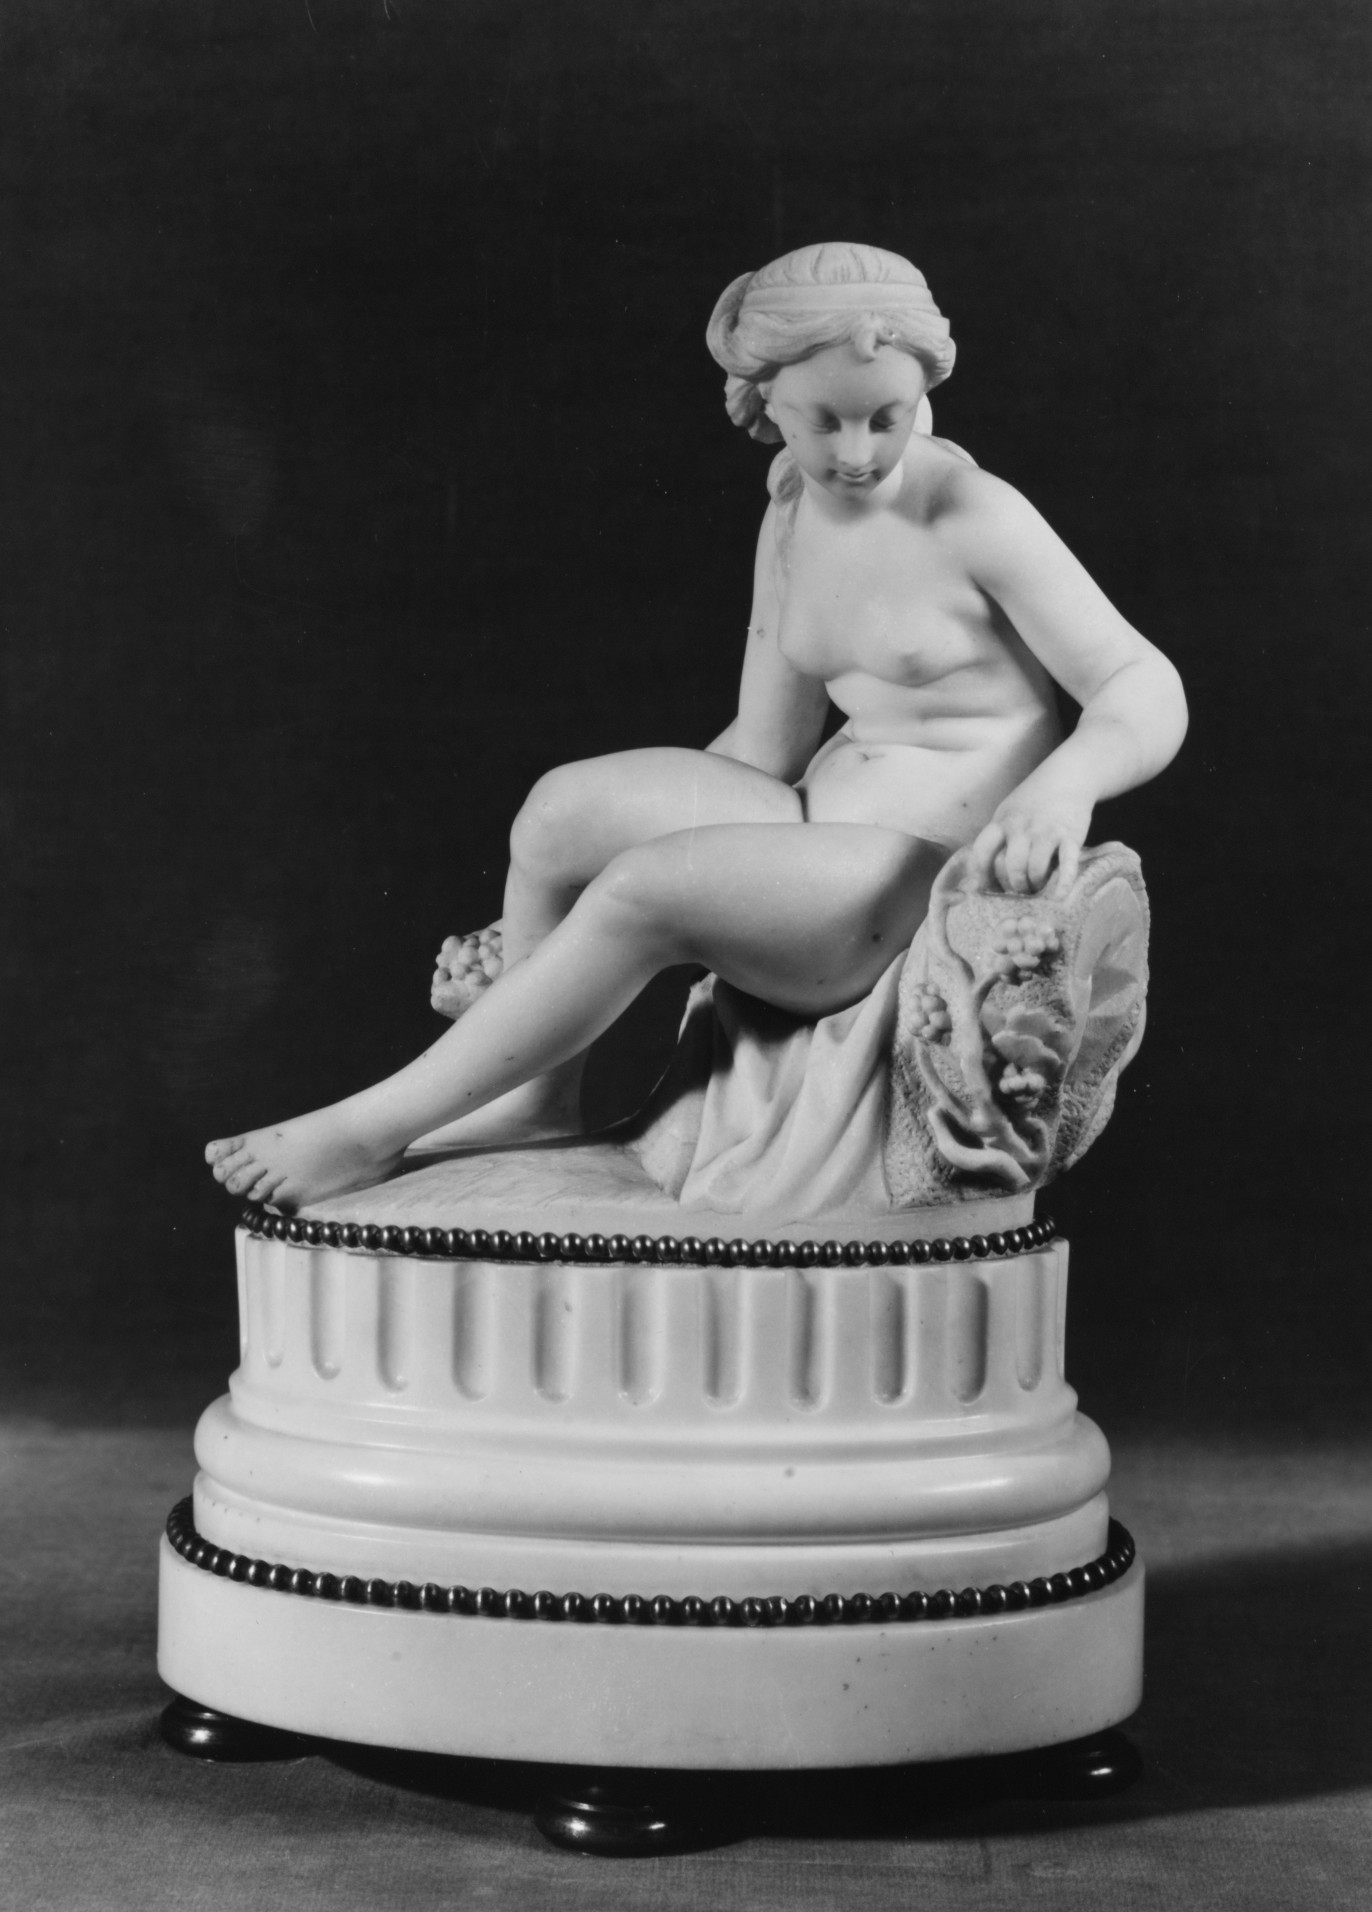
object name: statuette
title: Nymph (Spring) (one of a pair)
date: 1770-1780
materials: marble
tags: nymphs